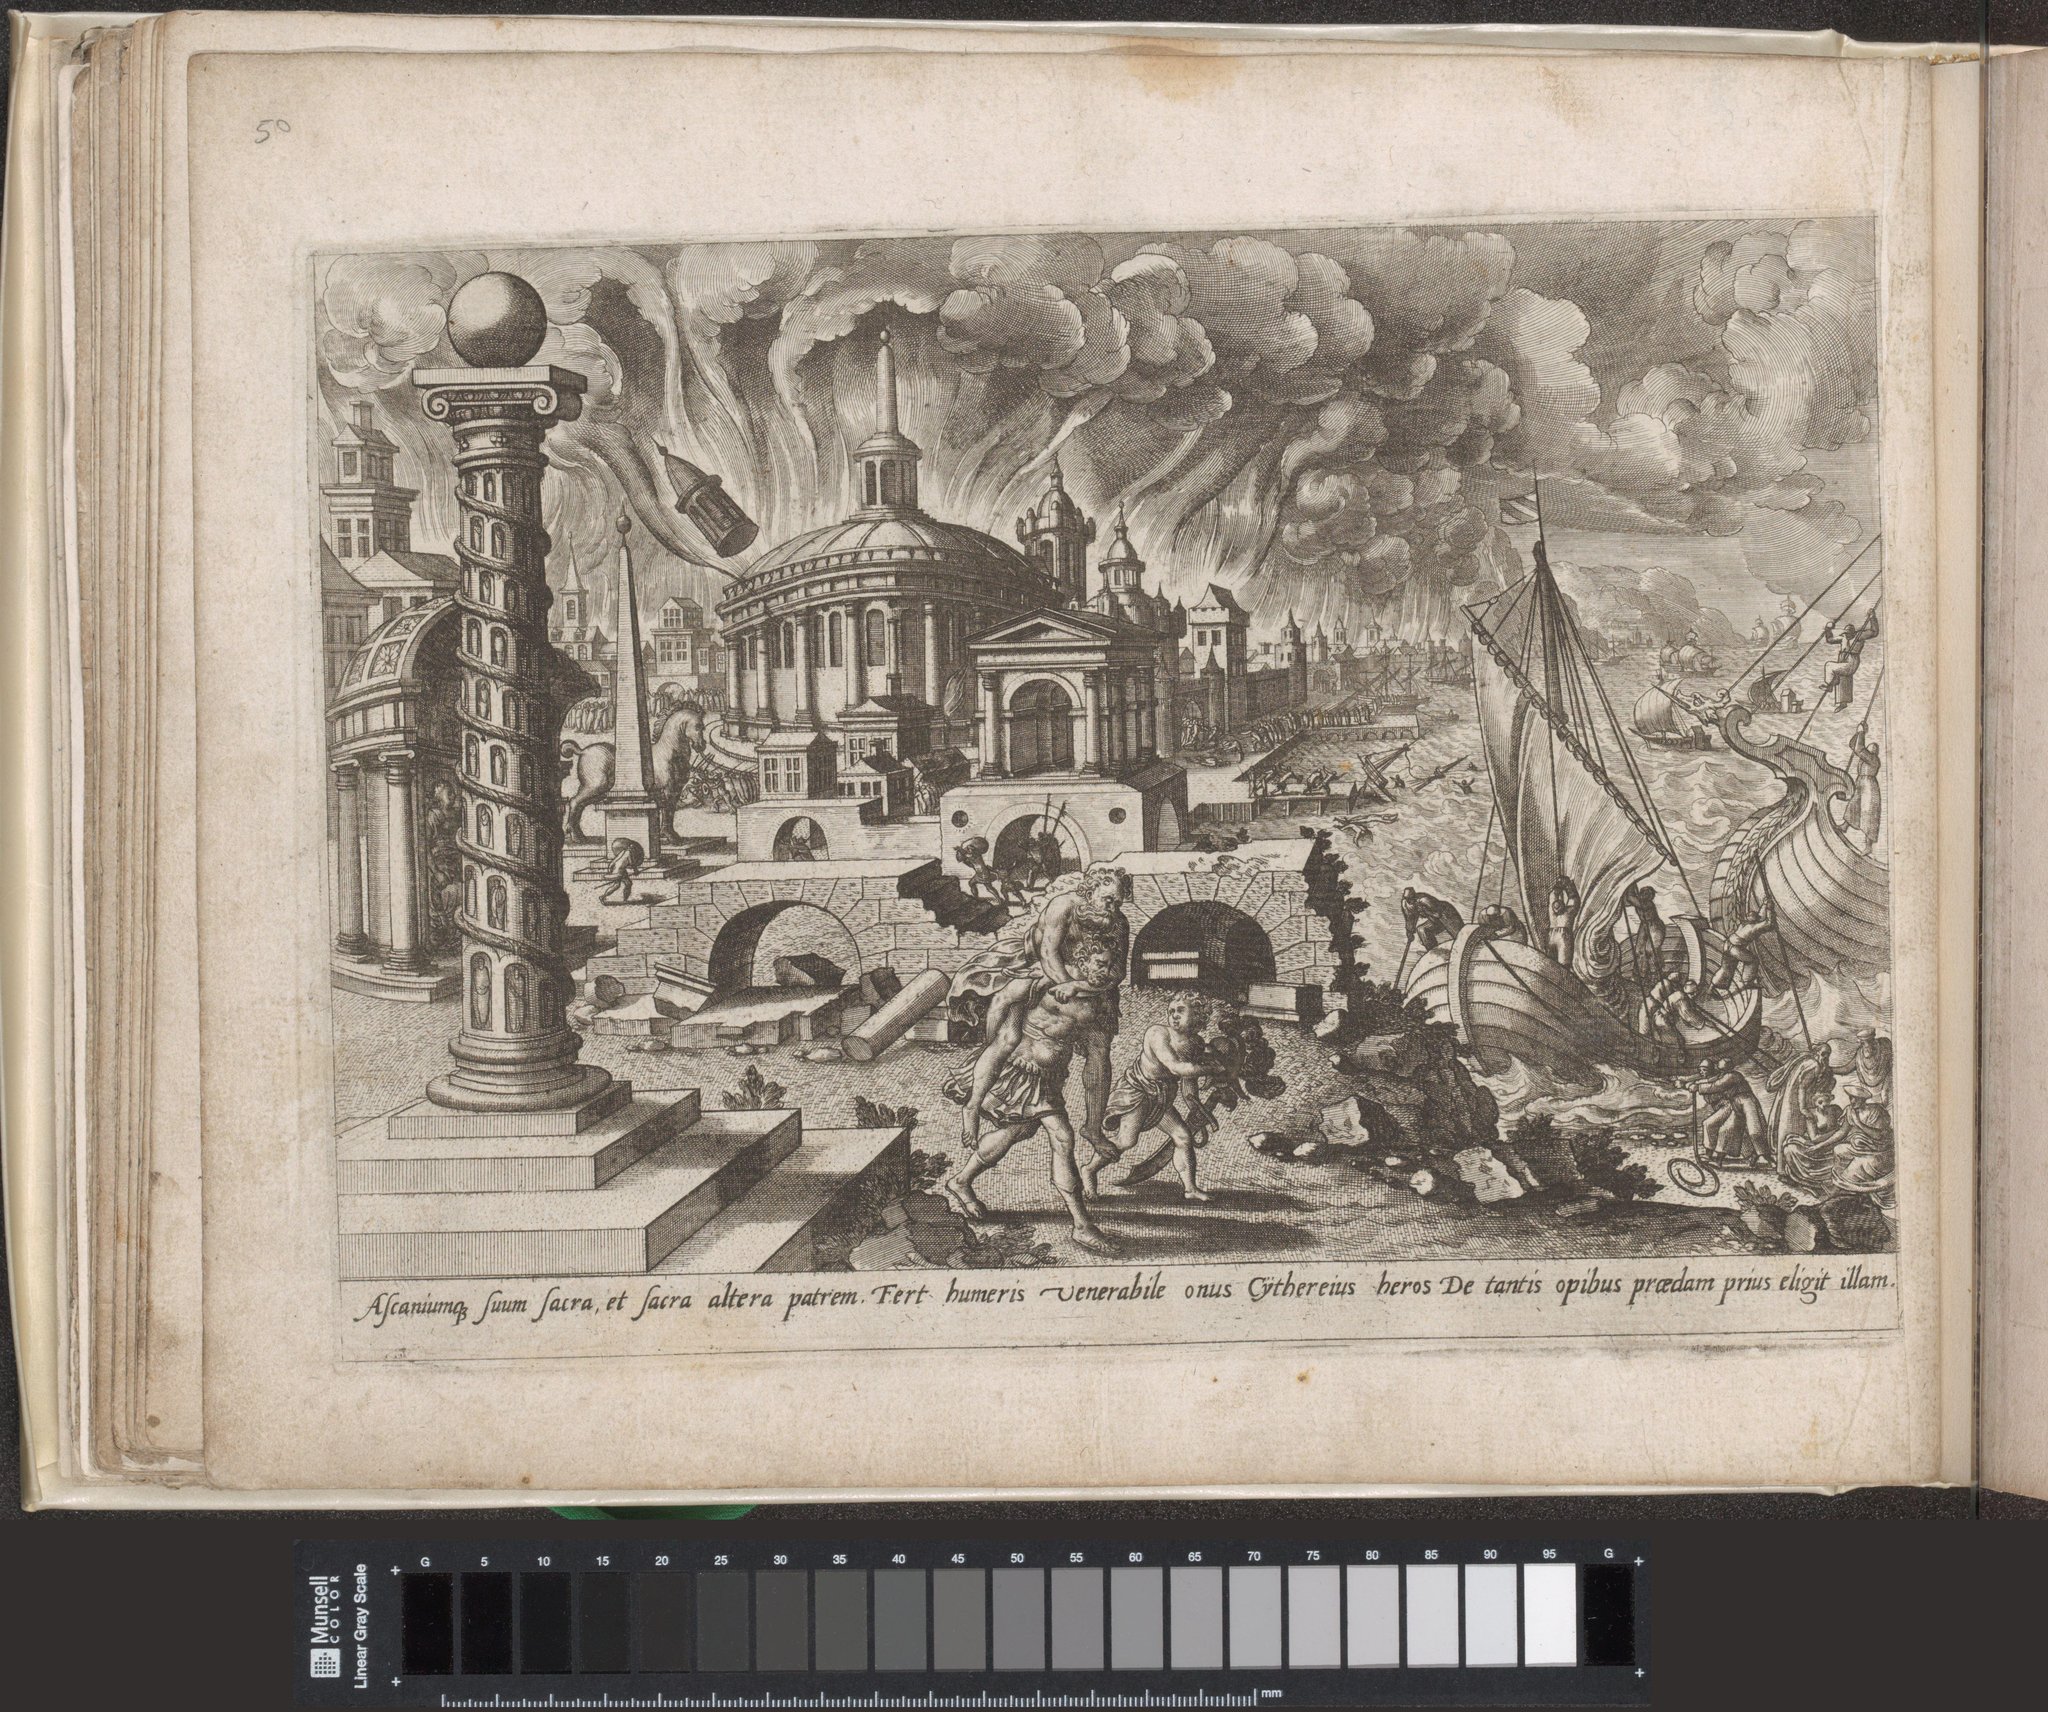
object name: album leaf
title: Aeneas redt zijn vader uit het brandende Troje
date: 1570-1574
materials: paper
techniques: etching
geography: antwerp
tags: 'pius aeneas': aeneas, leading ascanius, escapes from burning troy, carrying his father anchises with the penates; his wife creusa, who sets out with them, is lost on the way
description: Aeneas ontkomt uit het brandende Troje met zijn oude vader Anchises op zijn rug. Naast hem loopt zijn zoon Ascanius, die de helm en het zwaard van zijn vader draagt. Onder de voorstelling een verklarende tekst in het Latijn. Deze prent maakt deel uit van een album.